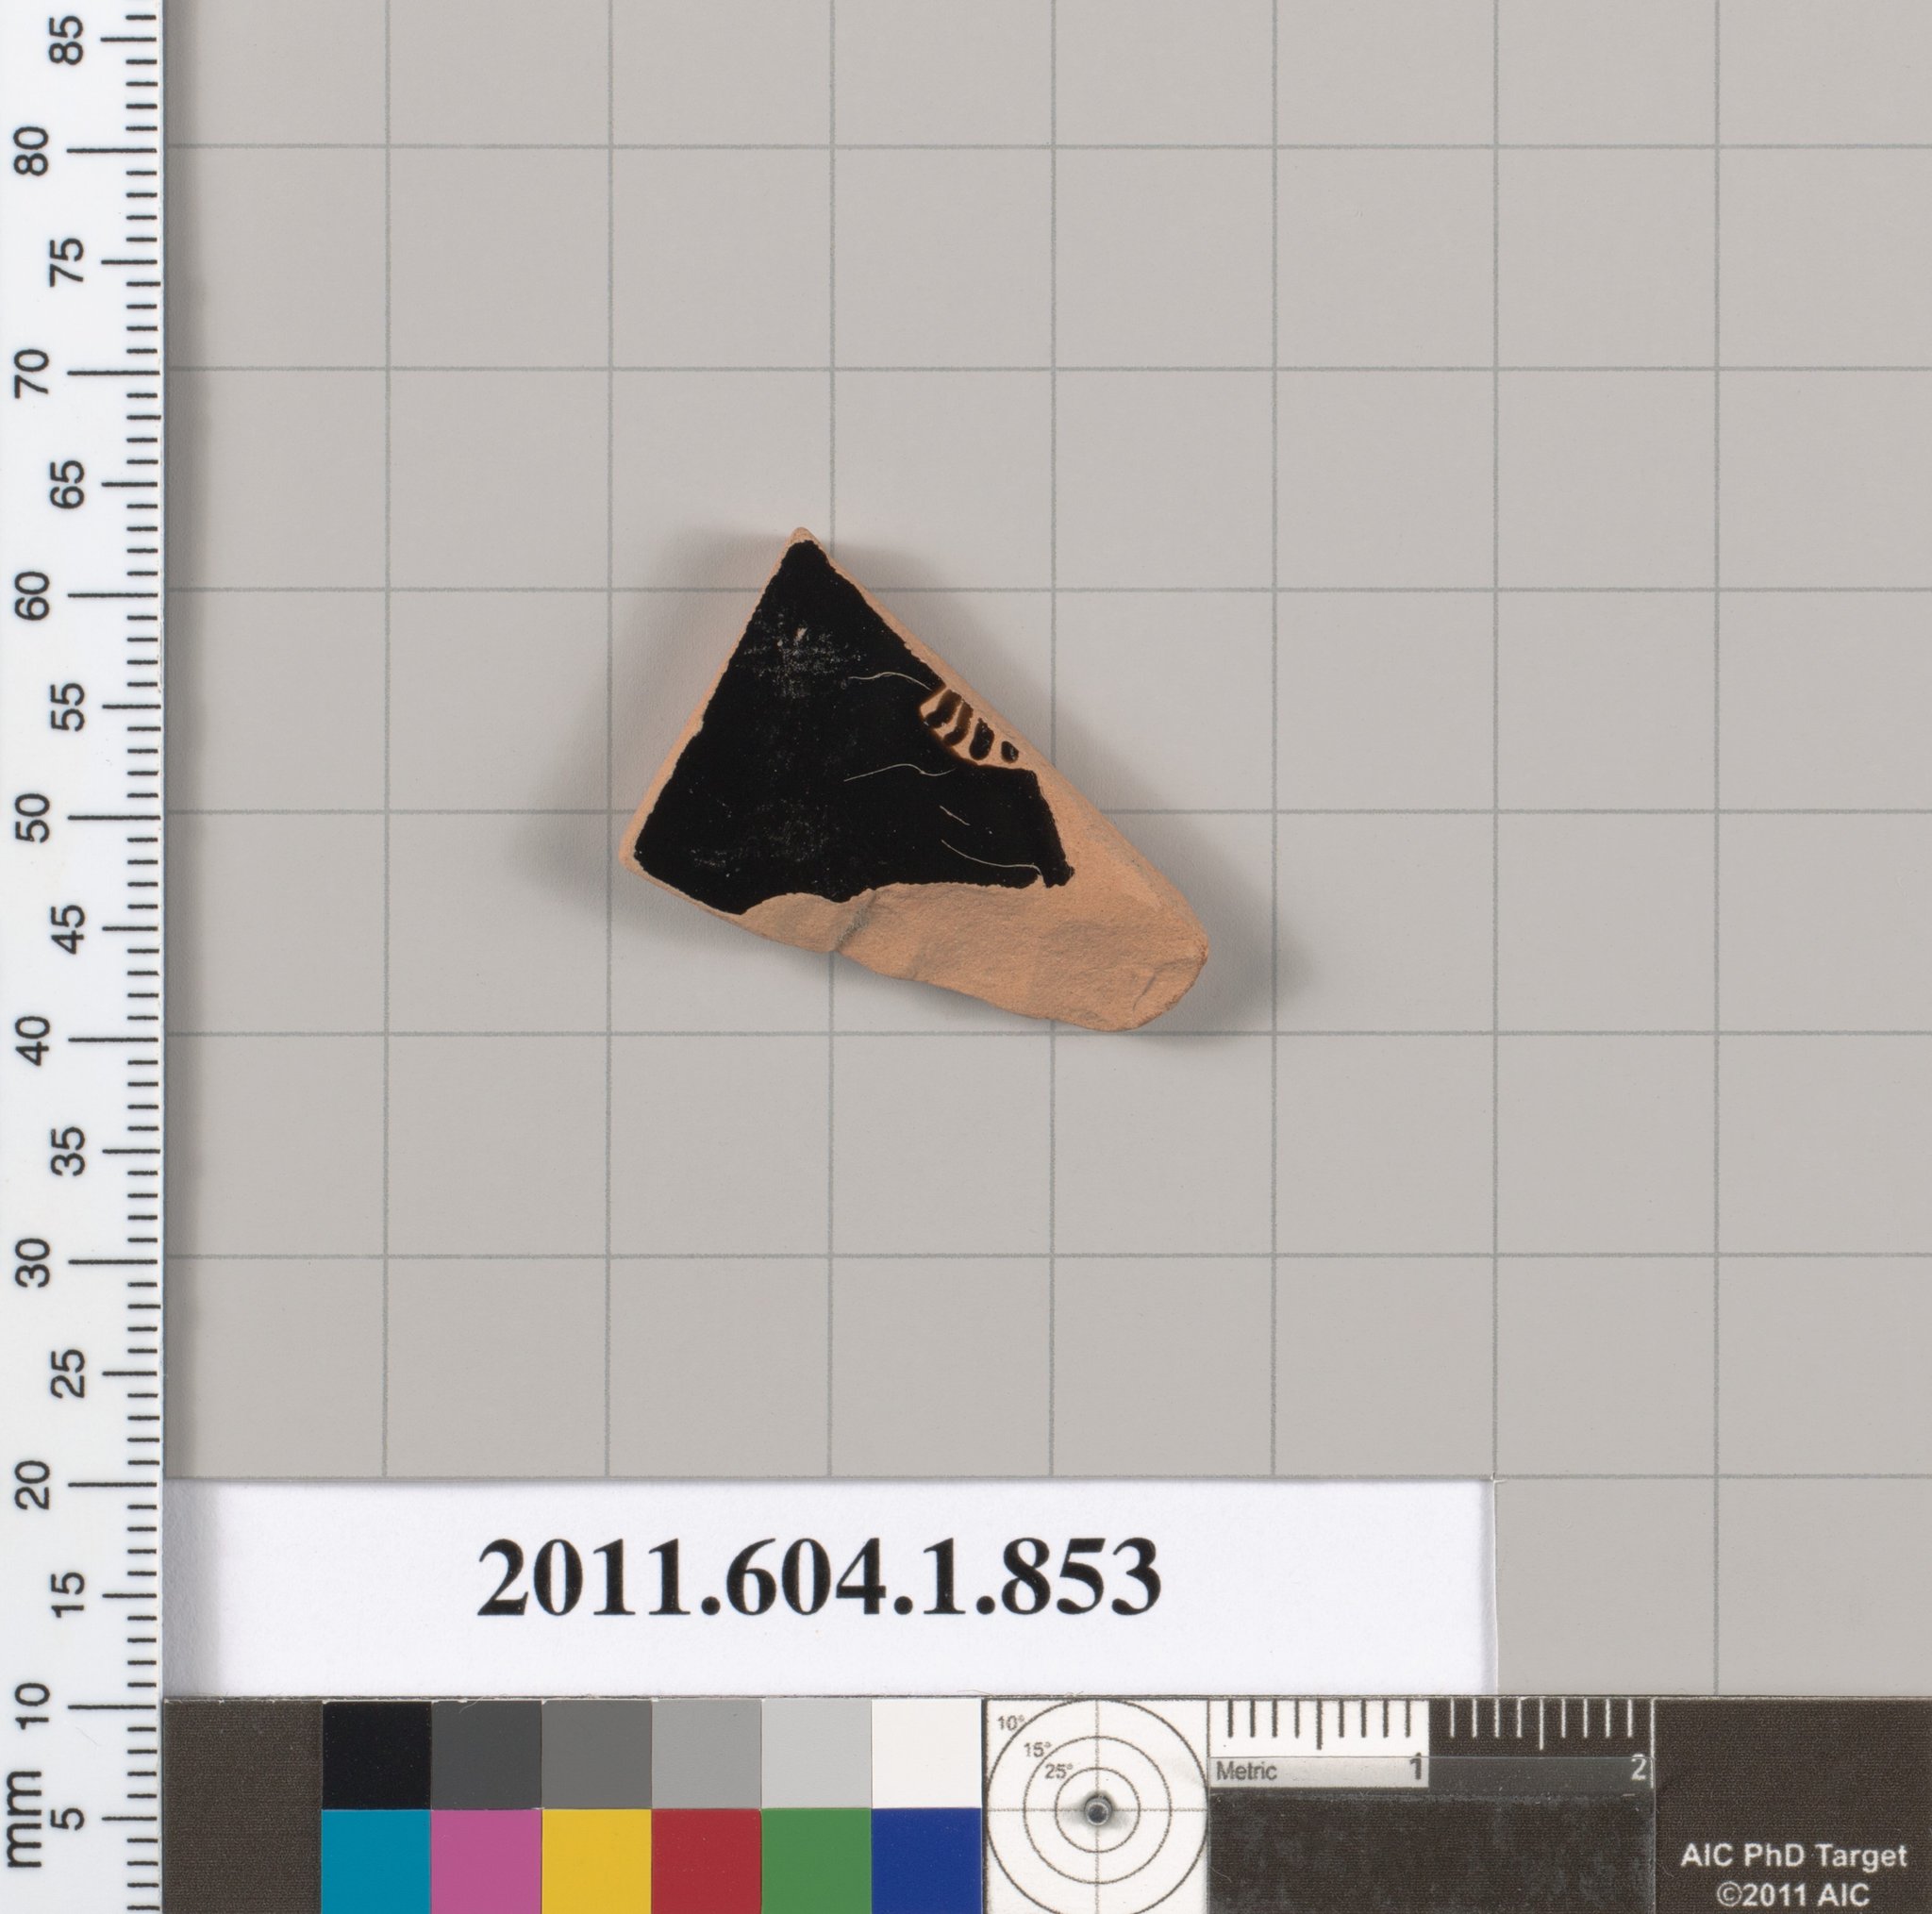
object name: kylix fragment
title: Terracotta fragment of a kylix (drinking cup)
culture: greek, attic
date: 475-451 BCE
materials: terracotta